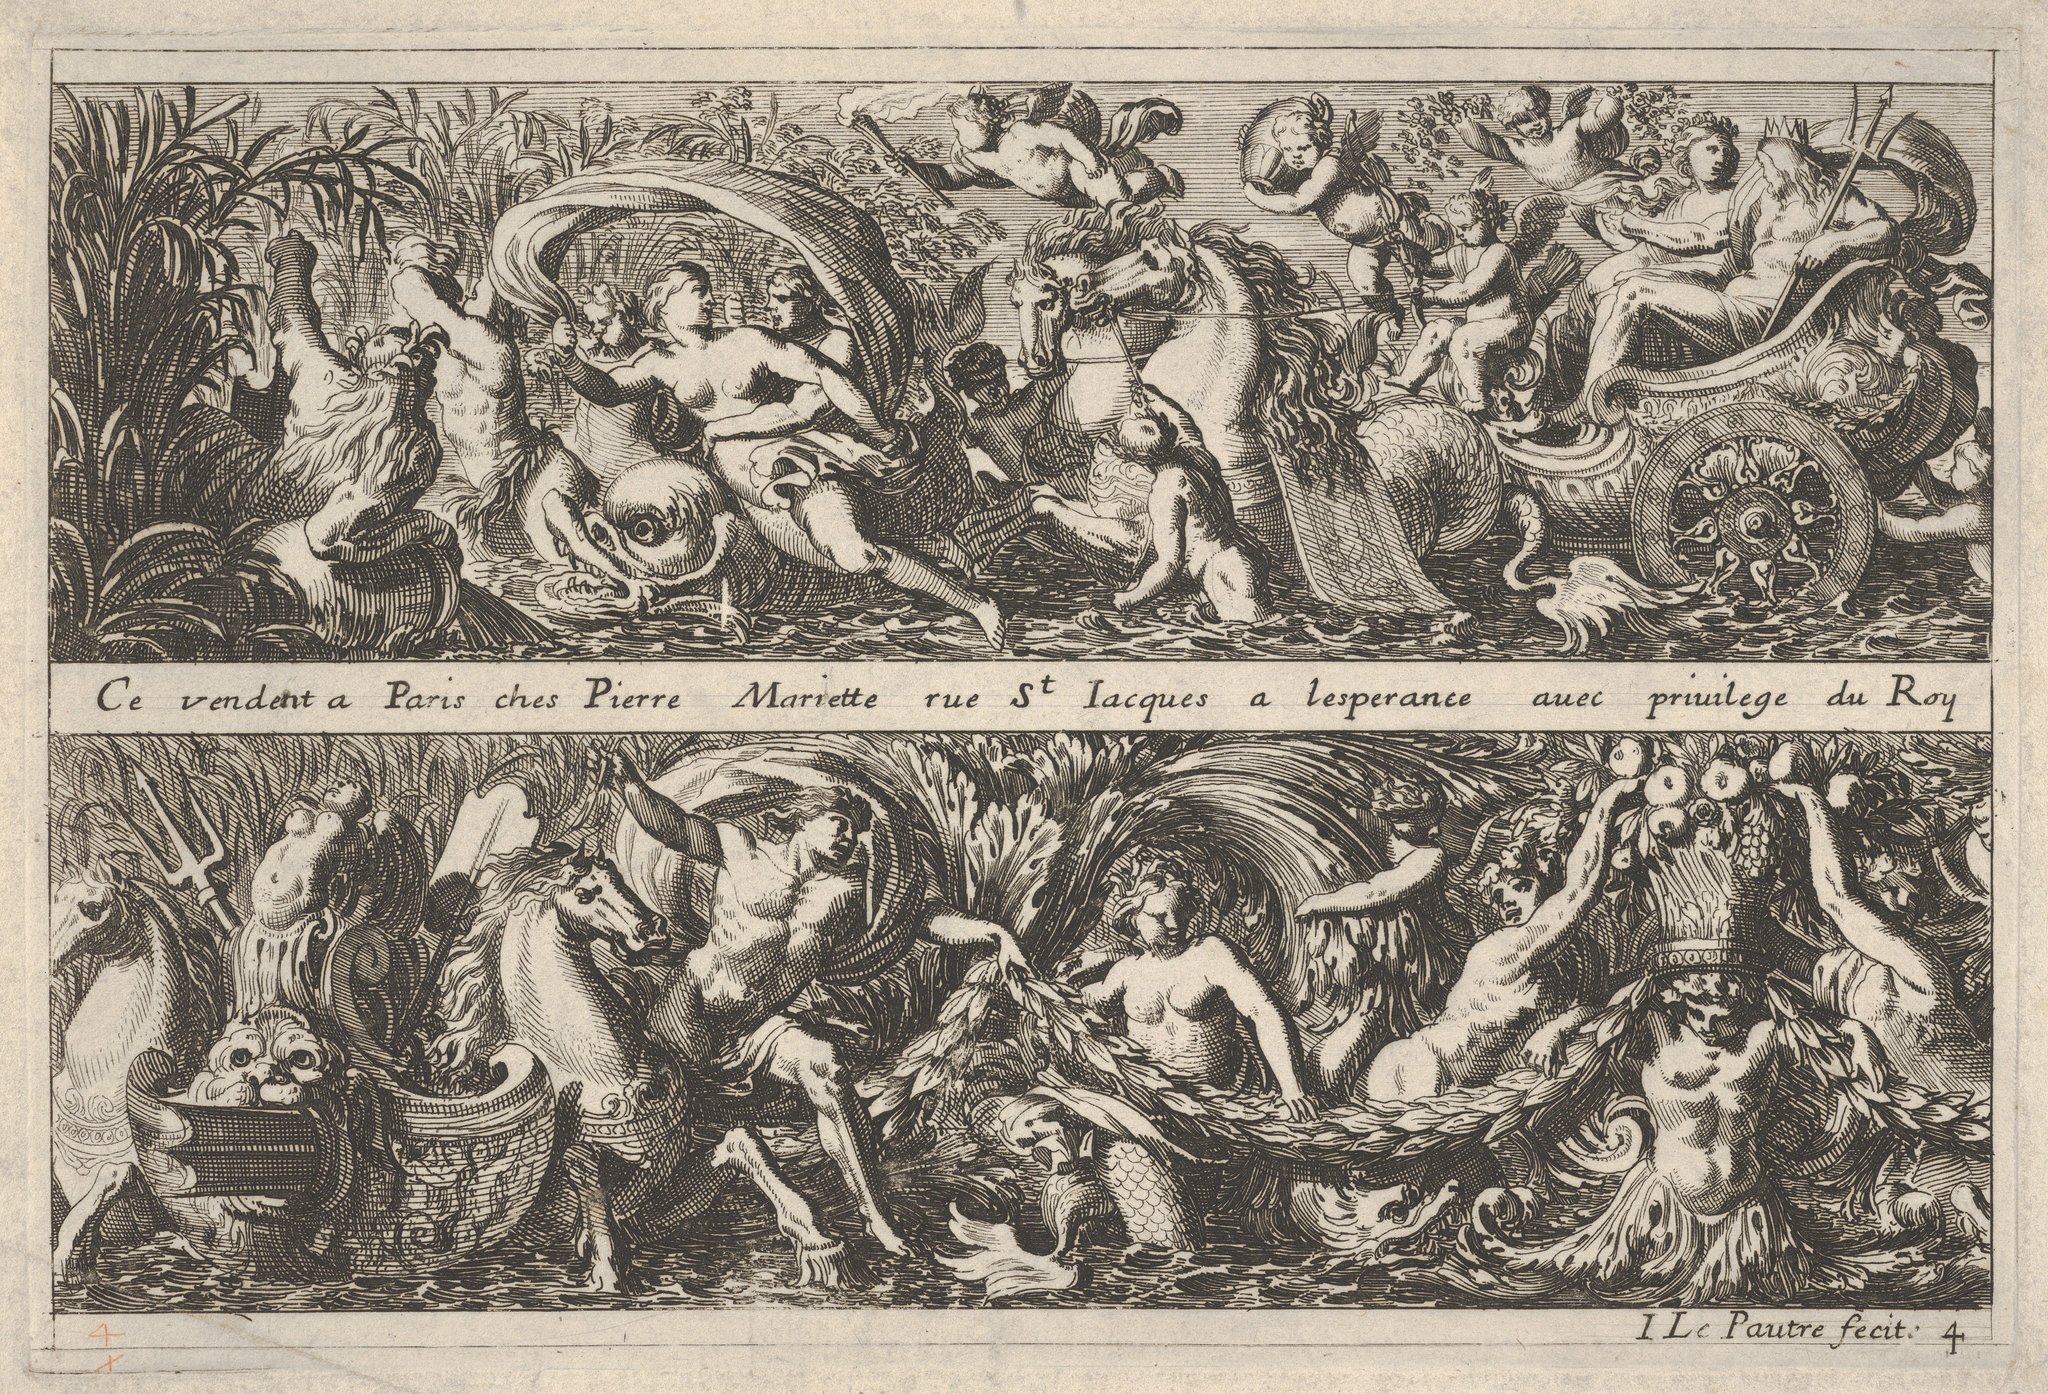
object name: print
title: Two Designs for Frieze Decorations with Sea Creatures, of which one features Neptune and Amphitrite, from "Frises, feuillages ou tritons marins antiques et modernes"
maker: jean le pautre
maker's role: artist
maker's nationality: french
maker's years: 1618-1682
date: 1640-1682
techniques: etching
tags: mythical creatures,neptune,chariots